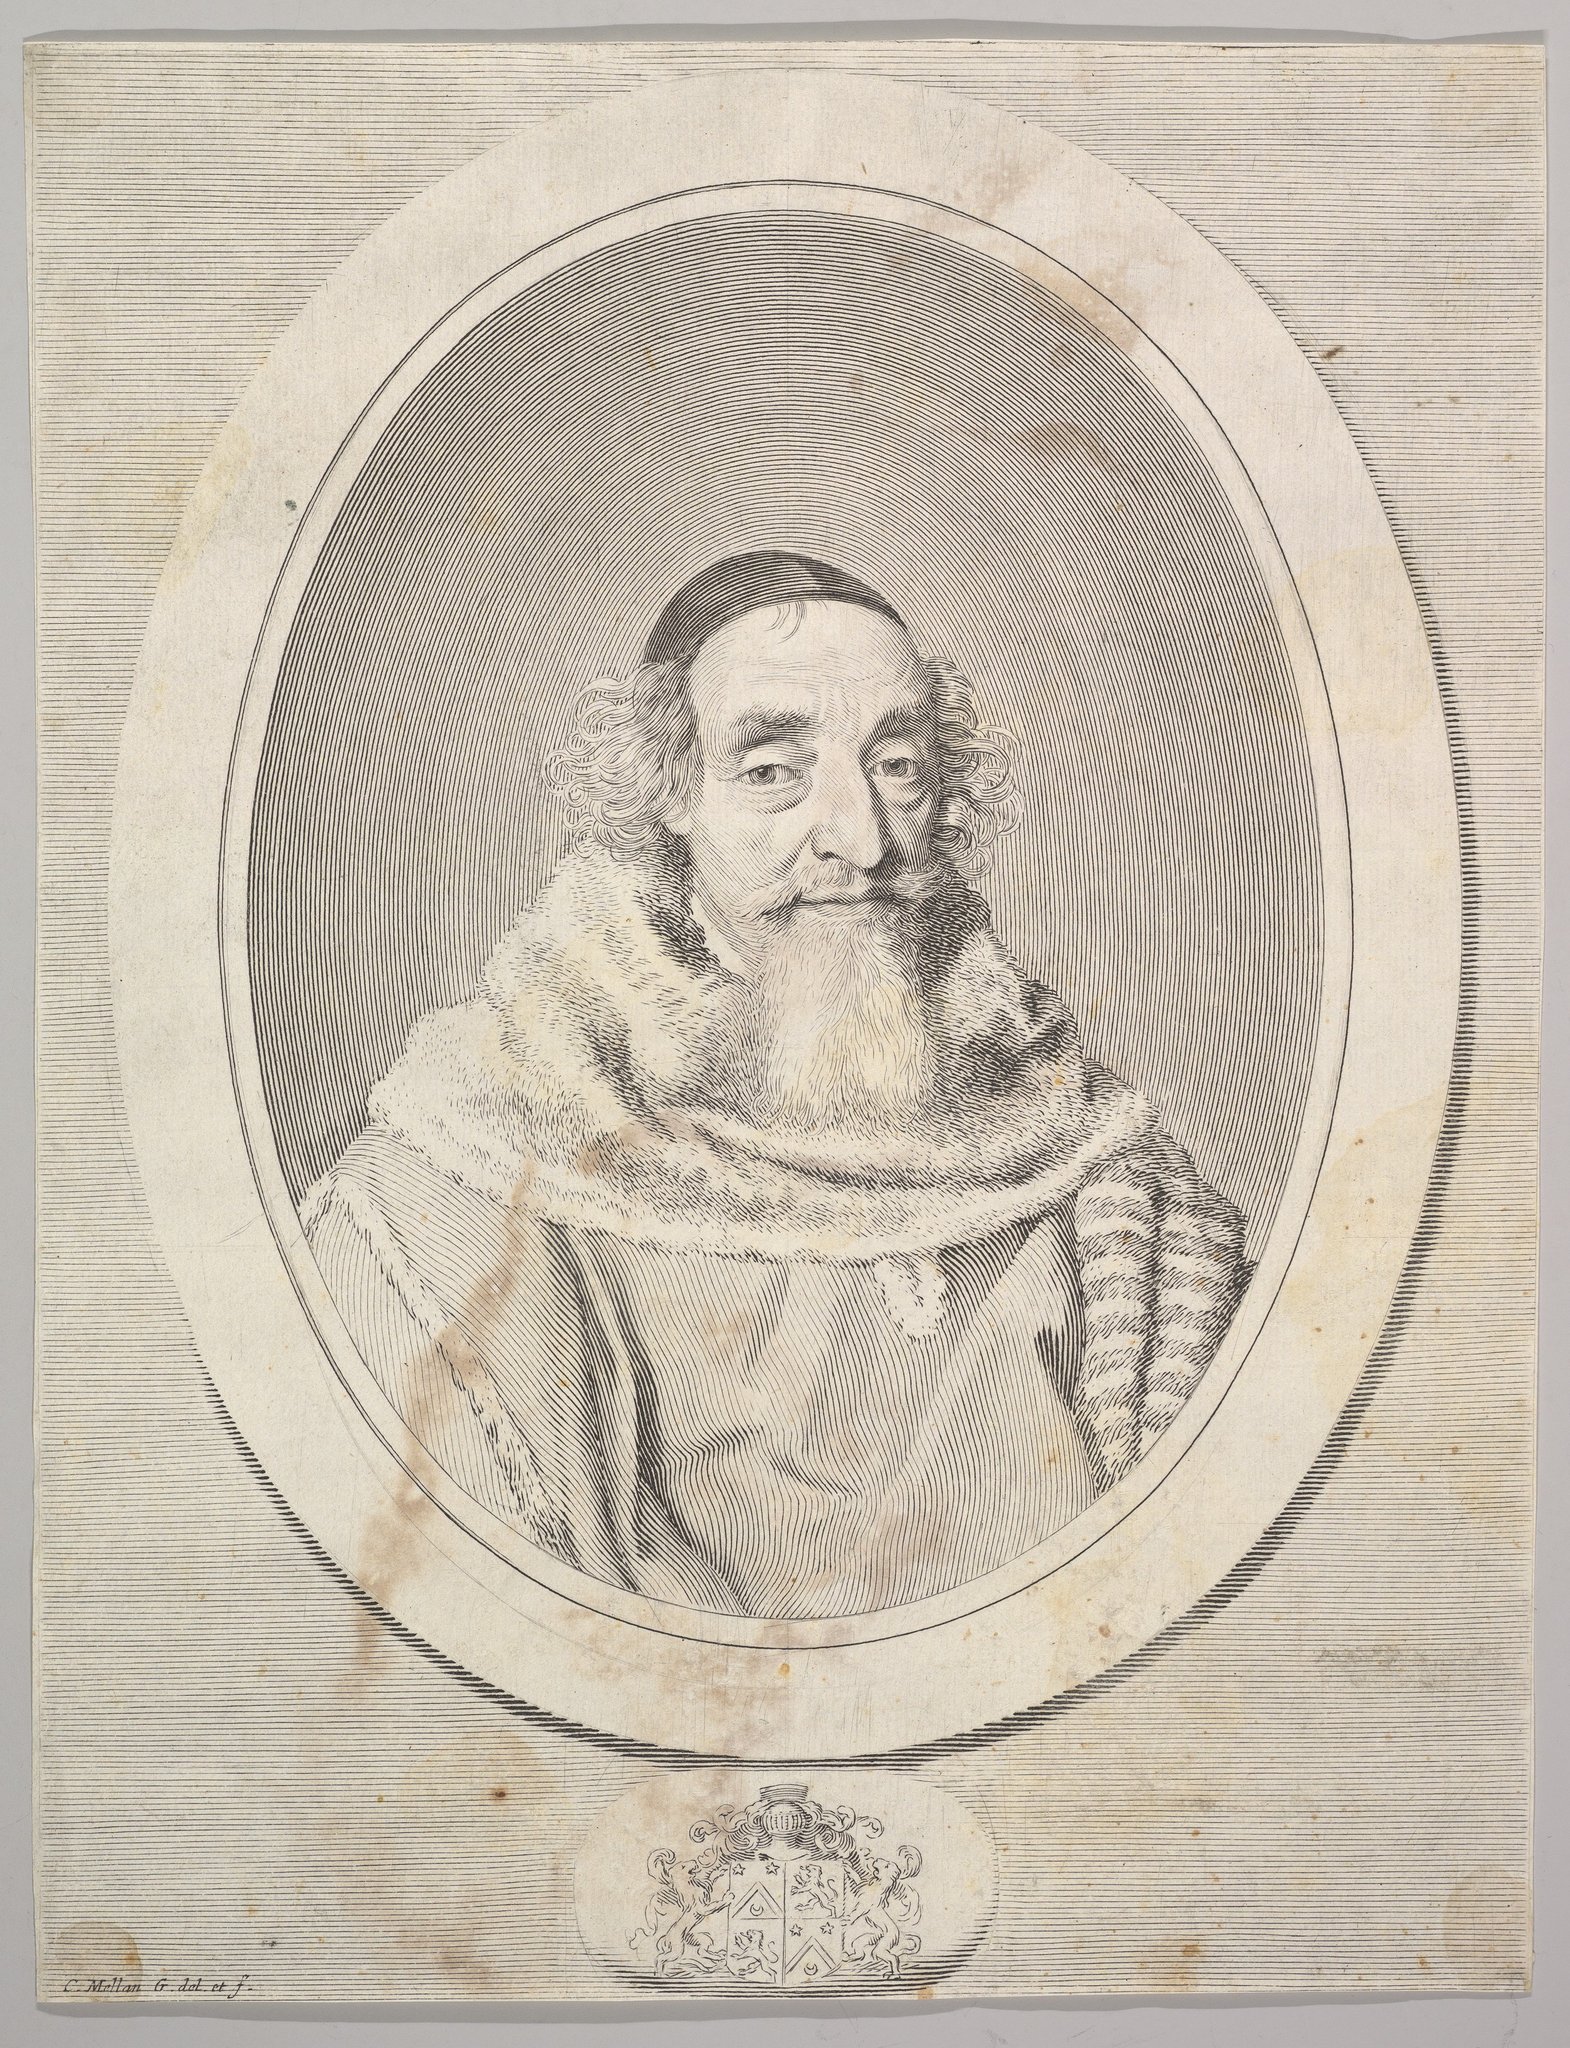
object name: print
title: Matthieu Molé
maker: claude mellan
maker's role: artist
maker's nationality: french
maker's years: 1598-1688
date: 1640-1656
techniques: engraving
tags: men,portraits